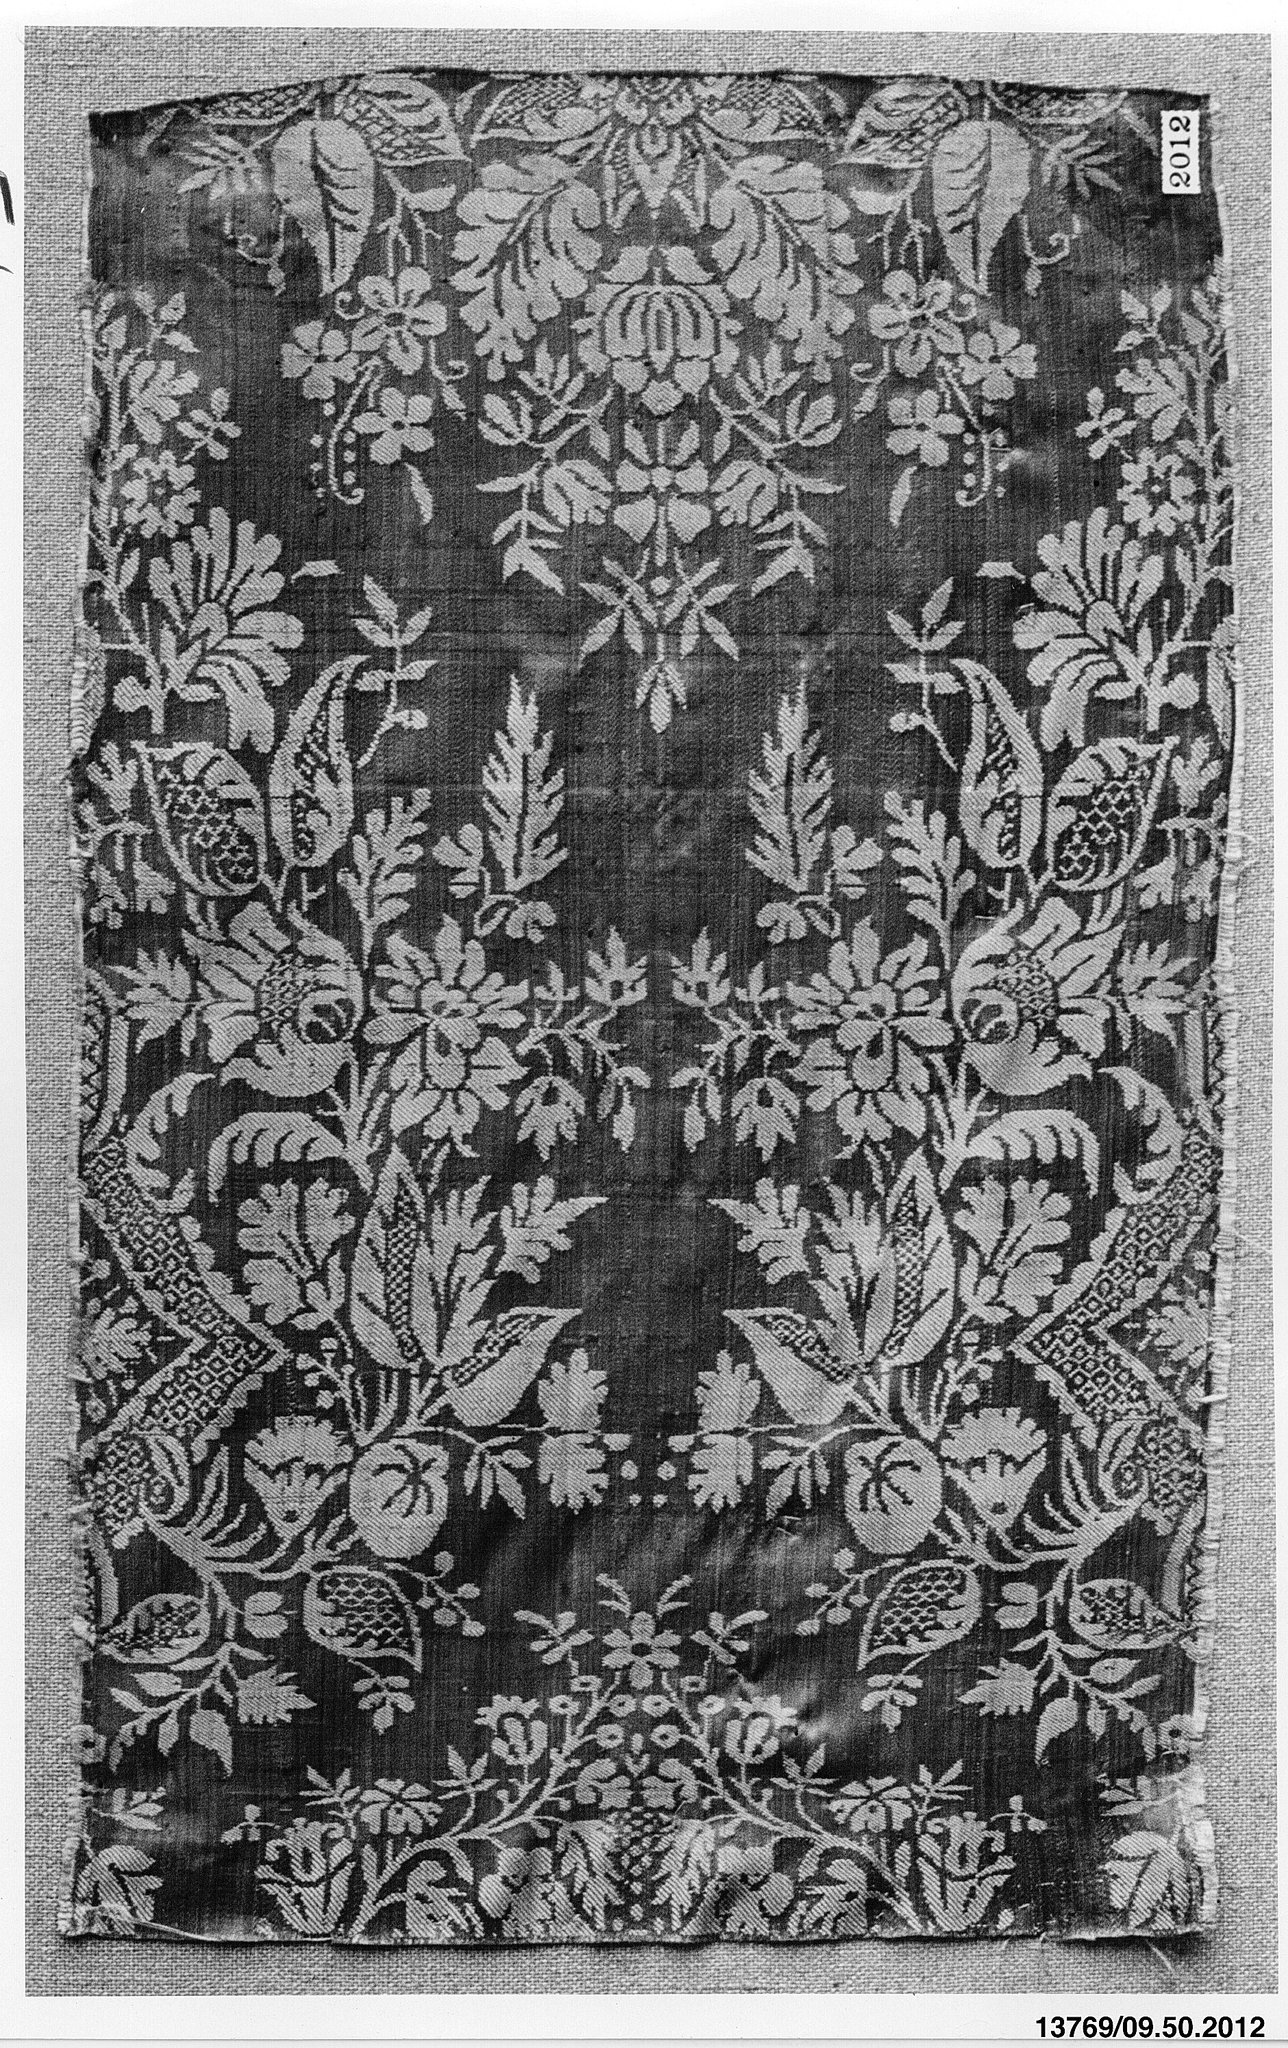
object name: piece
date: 1701-1800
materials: silk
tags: flowers,leaves